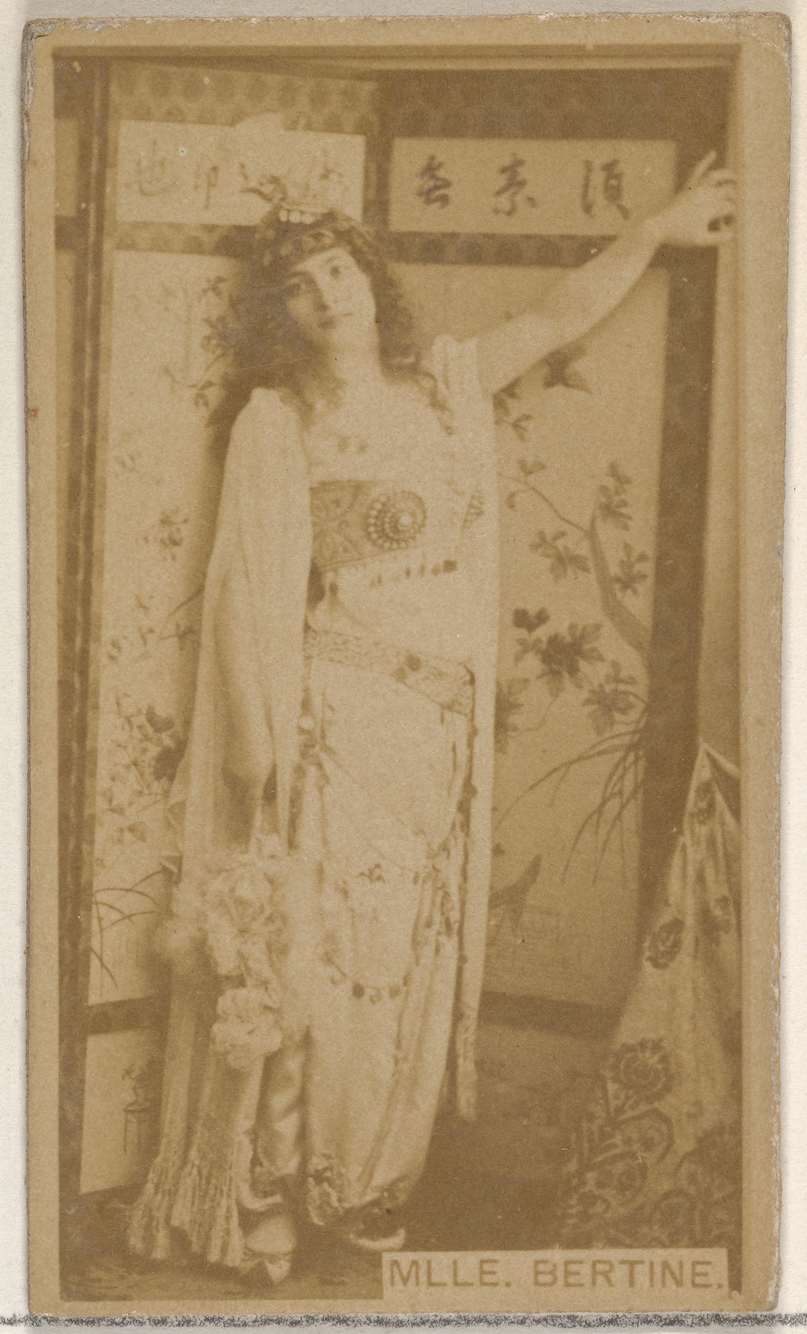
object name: photograph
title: Mlle. Bertine, from the Actors and Actresses series (N45, Type 8) for Virginia Brights Cigarettes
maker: allen & ginter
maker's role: publisher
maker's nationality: american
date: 1888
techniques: albumen silver print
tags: portraits,women,actresses